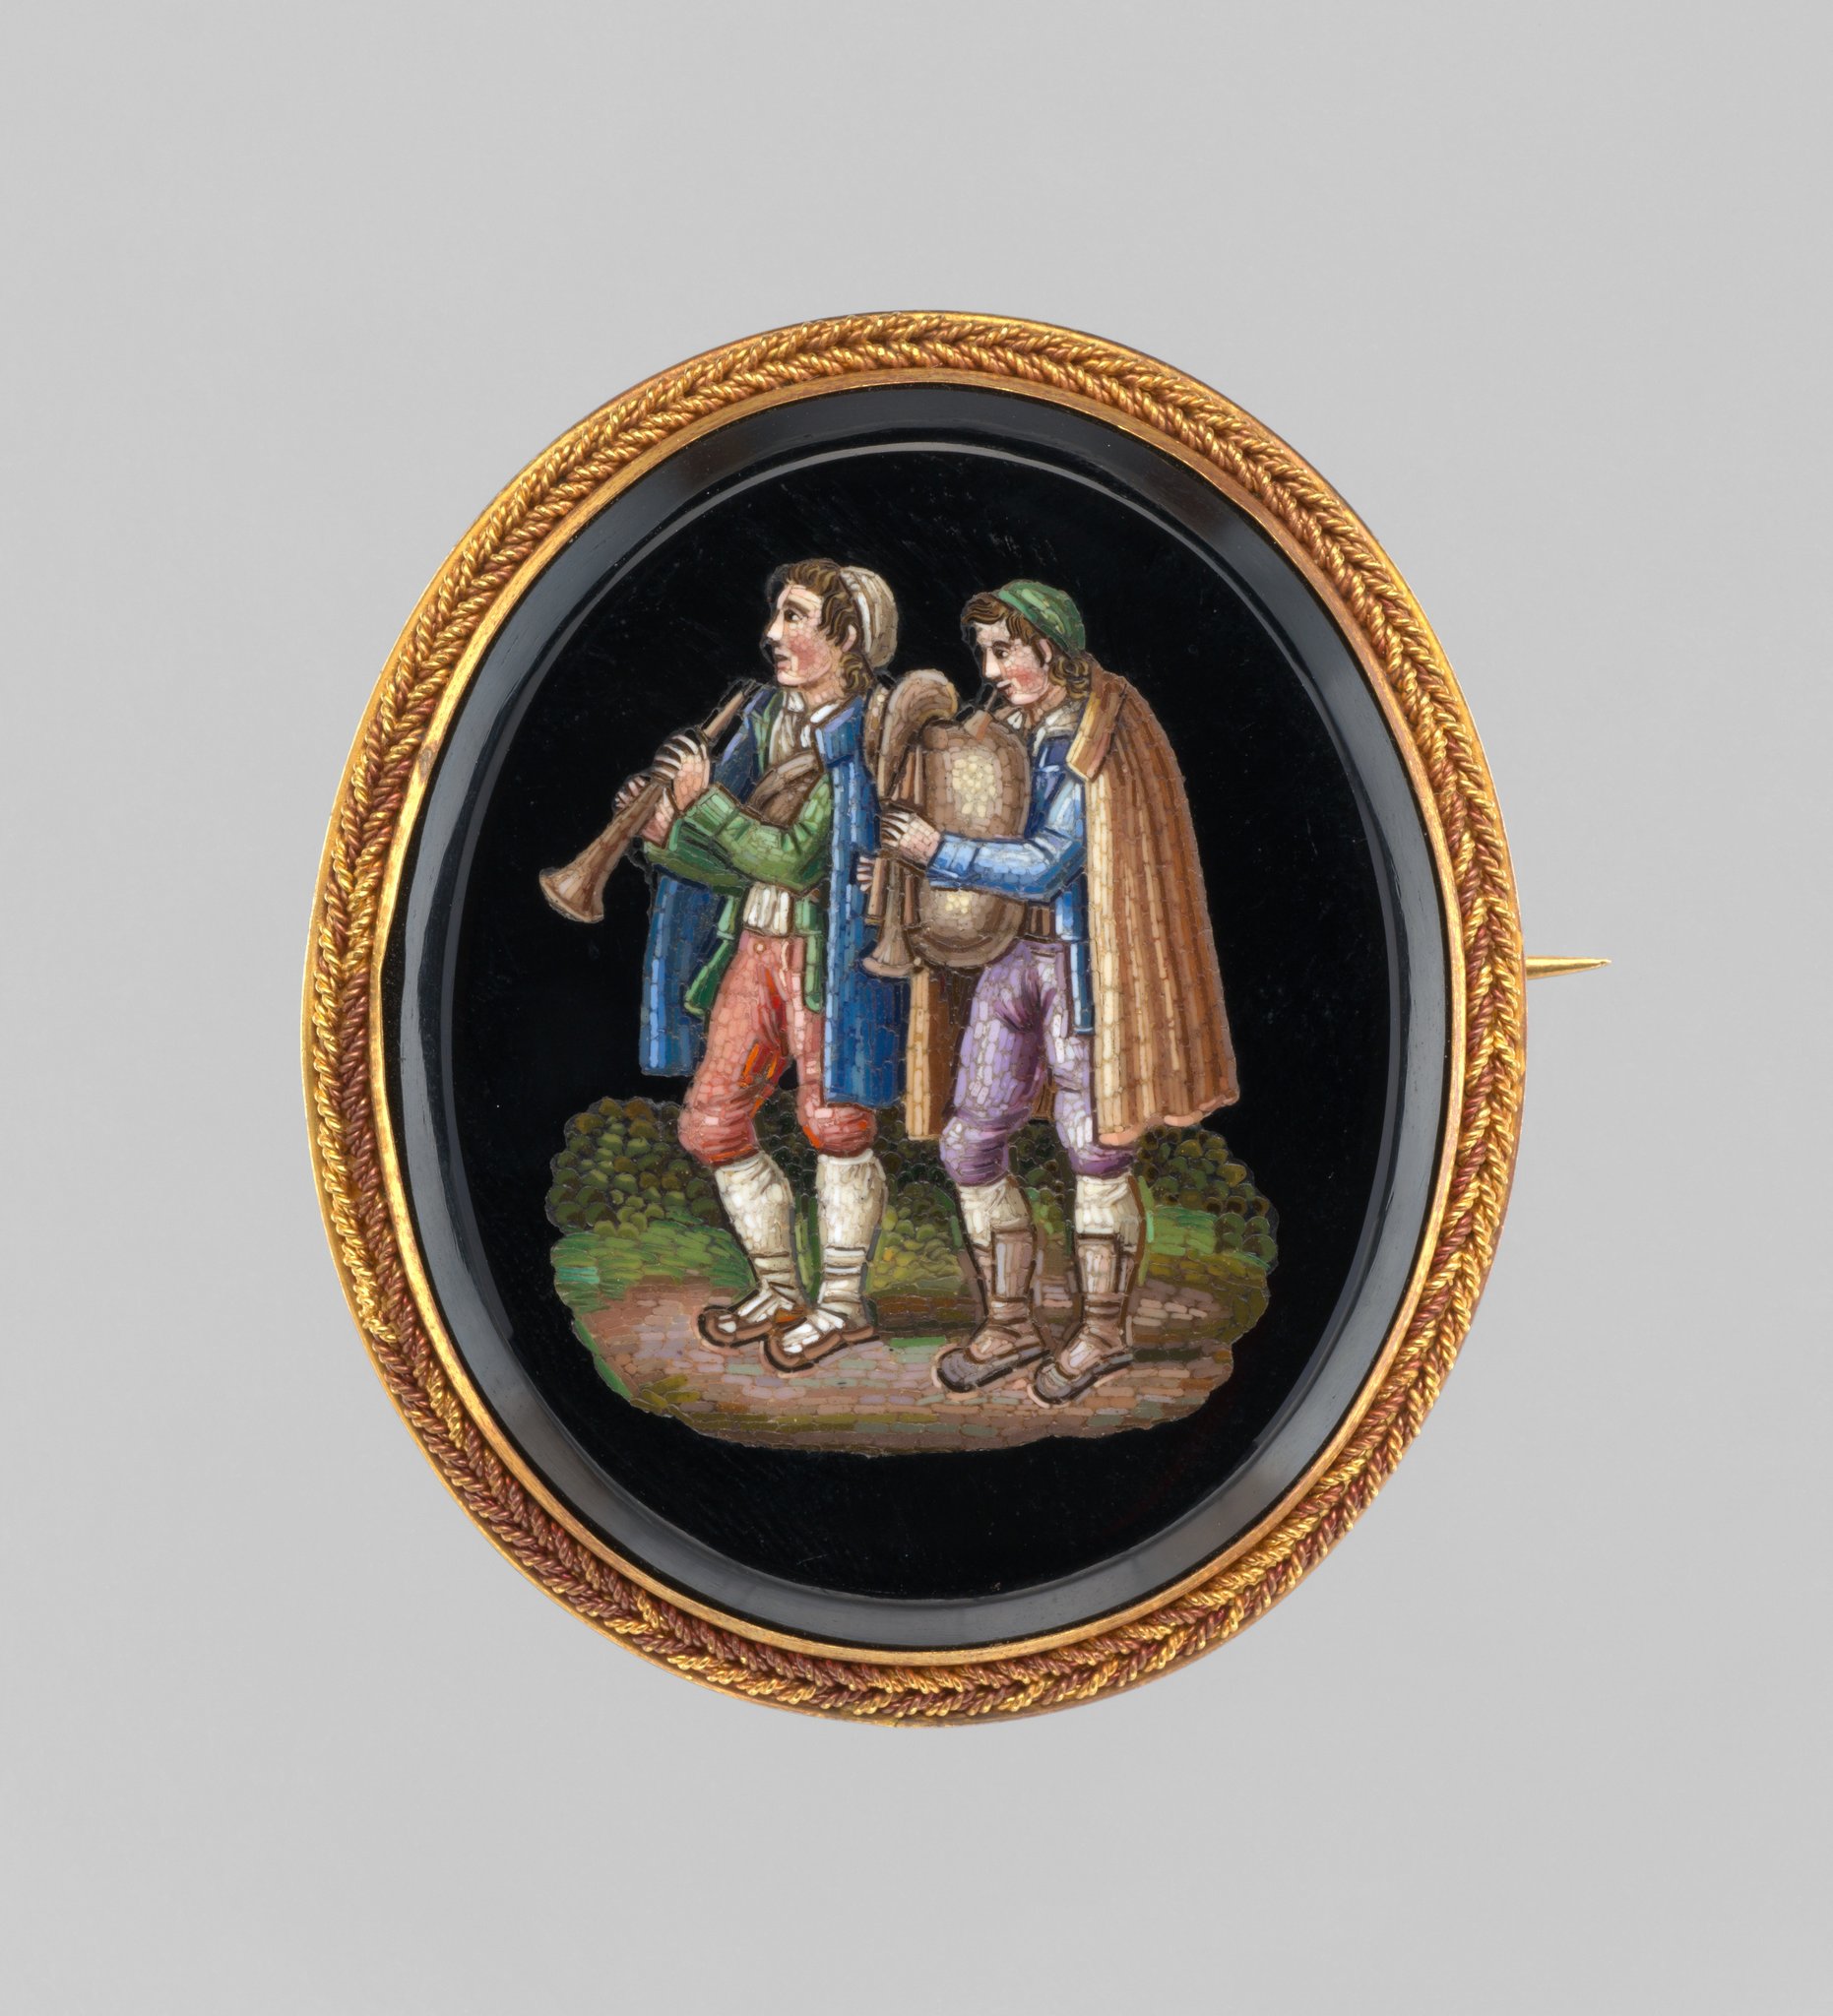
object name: brooch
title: Brooch (part of a set)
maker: g.l. barberi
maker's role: artist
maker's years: 1800-1900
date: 1801-1900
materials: glass, gold, onyx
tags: men,bagpipes